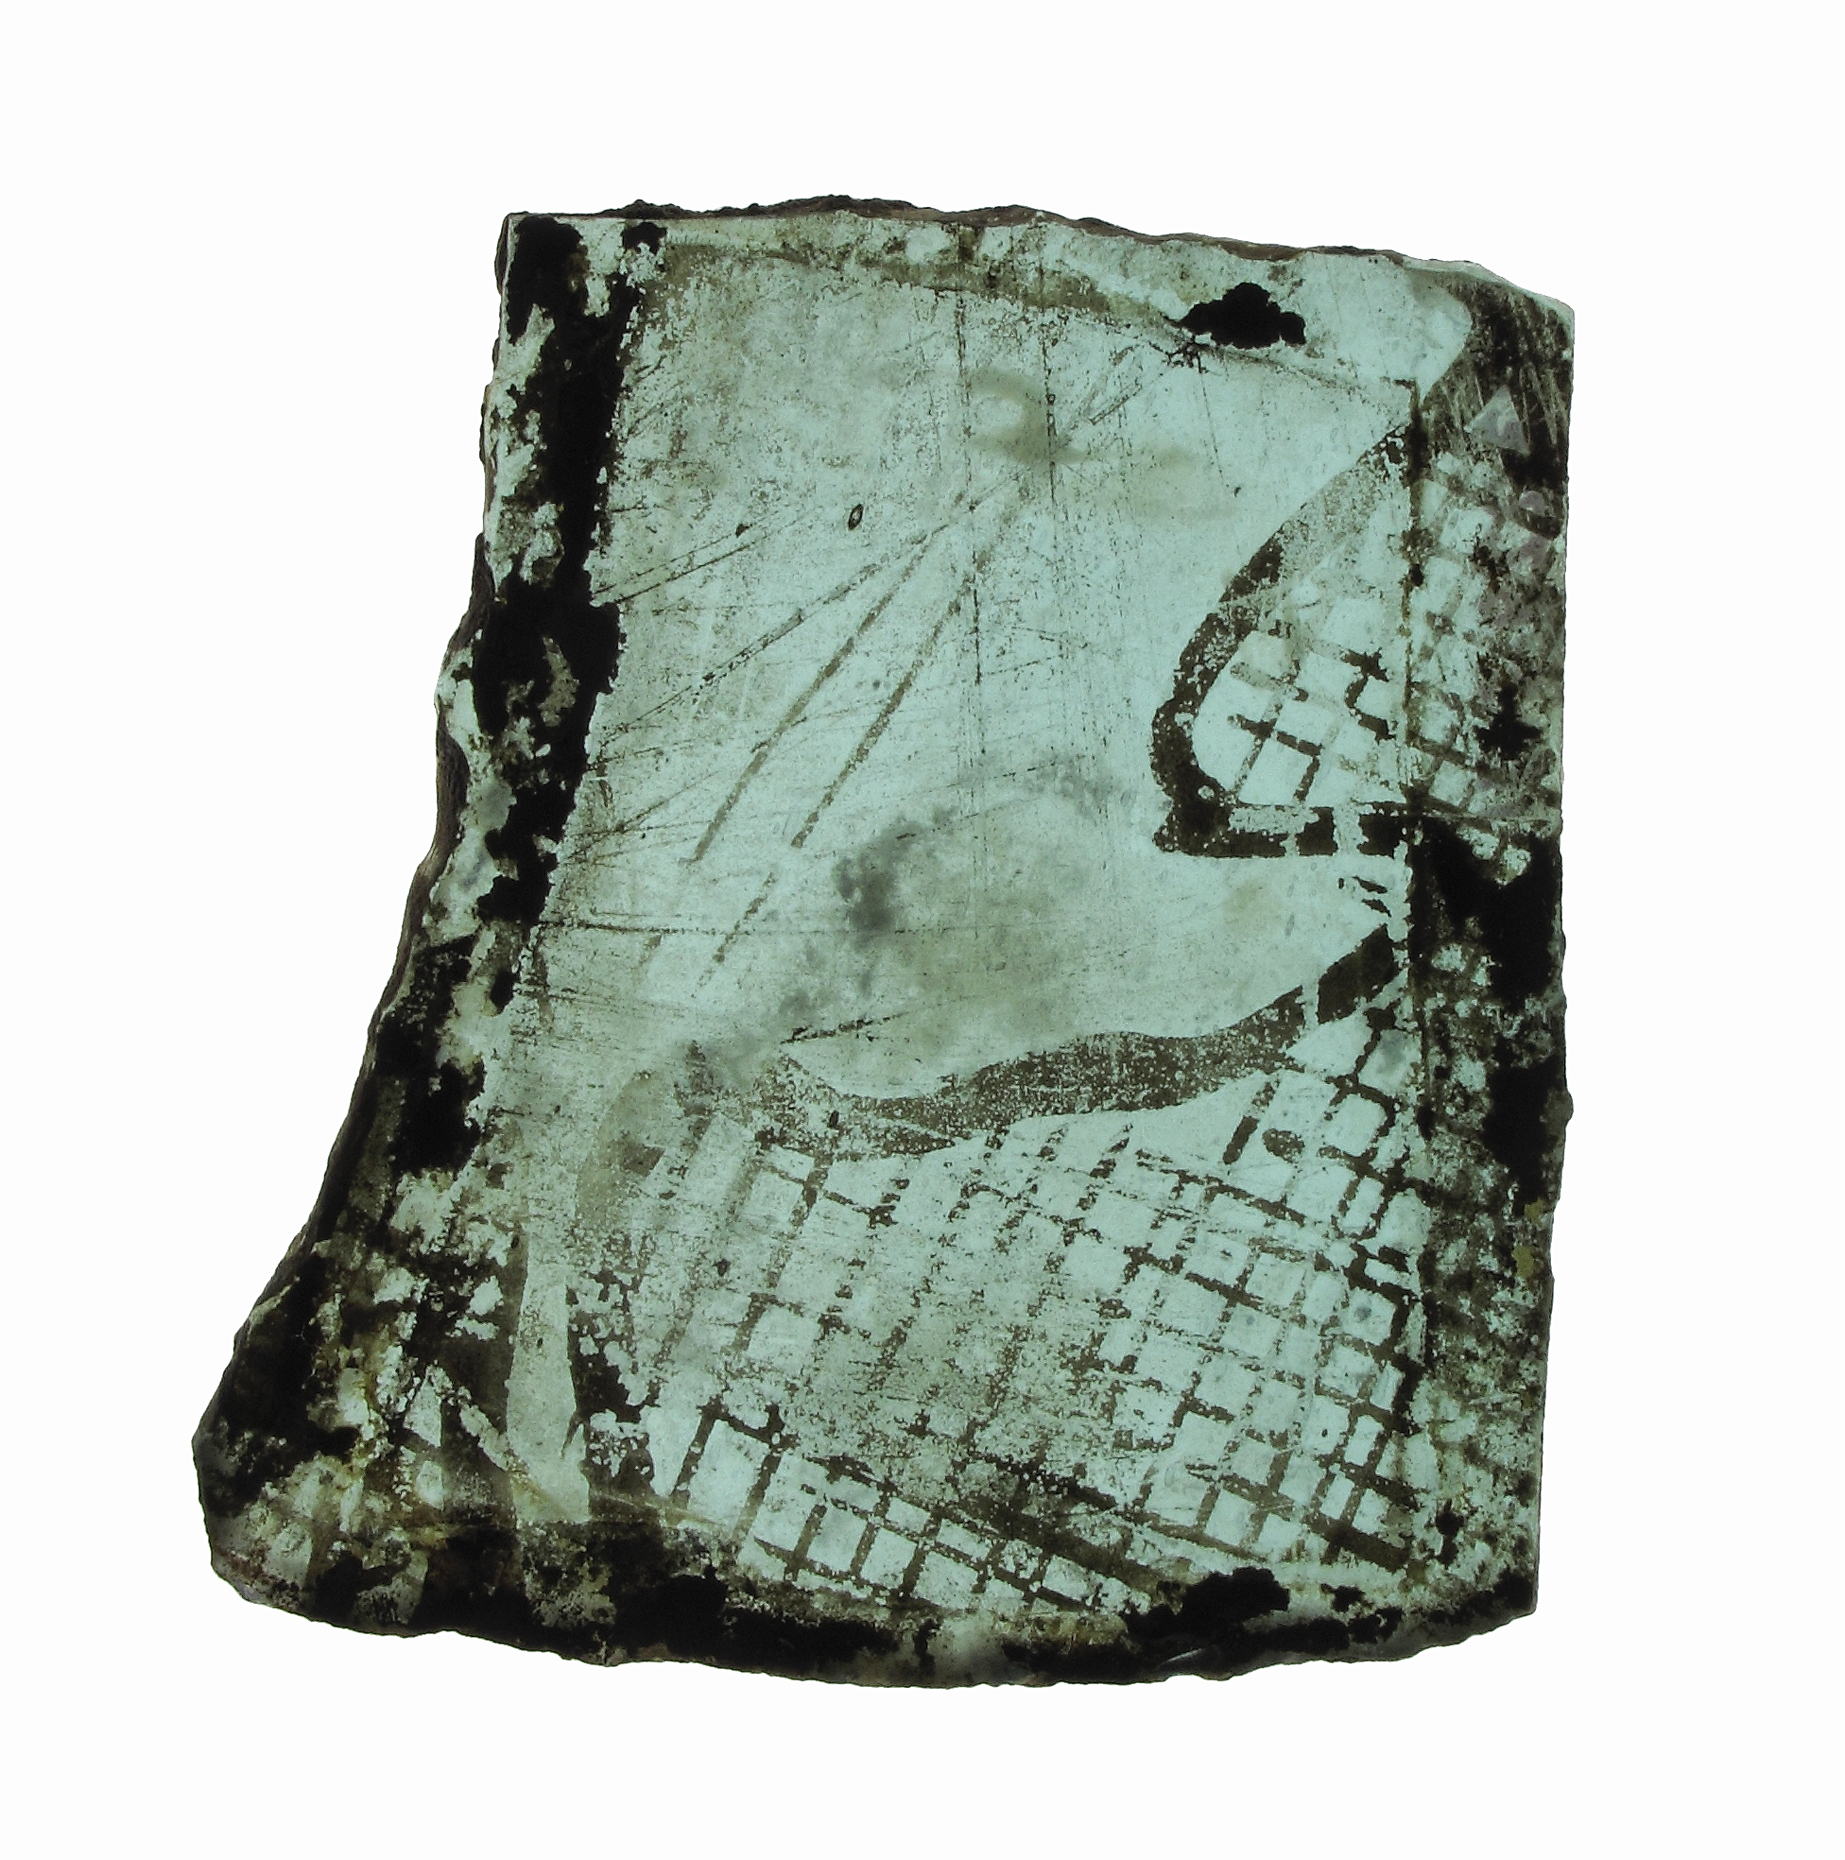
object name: fragment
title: Glass Fragment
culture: british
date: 1301-1400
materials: glass